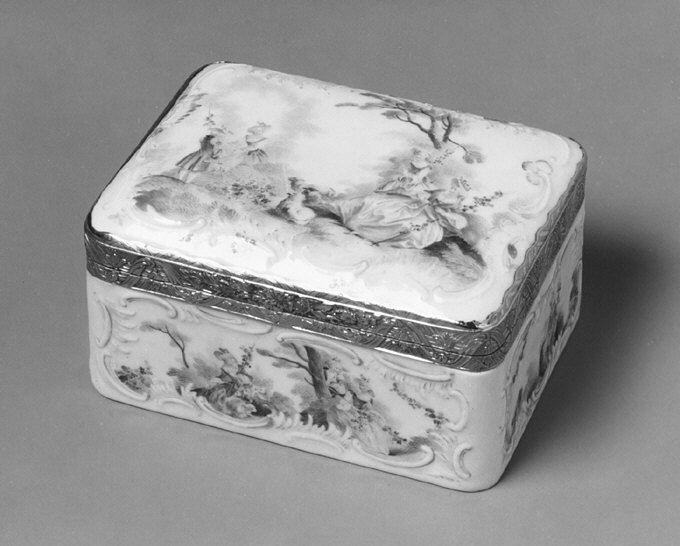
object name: snuffbox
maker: meissen manufactory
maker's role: manufactory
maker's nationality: german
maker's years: 1710-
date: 1760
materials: gold, hard paste porcelain